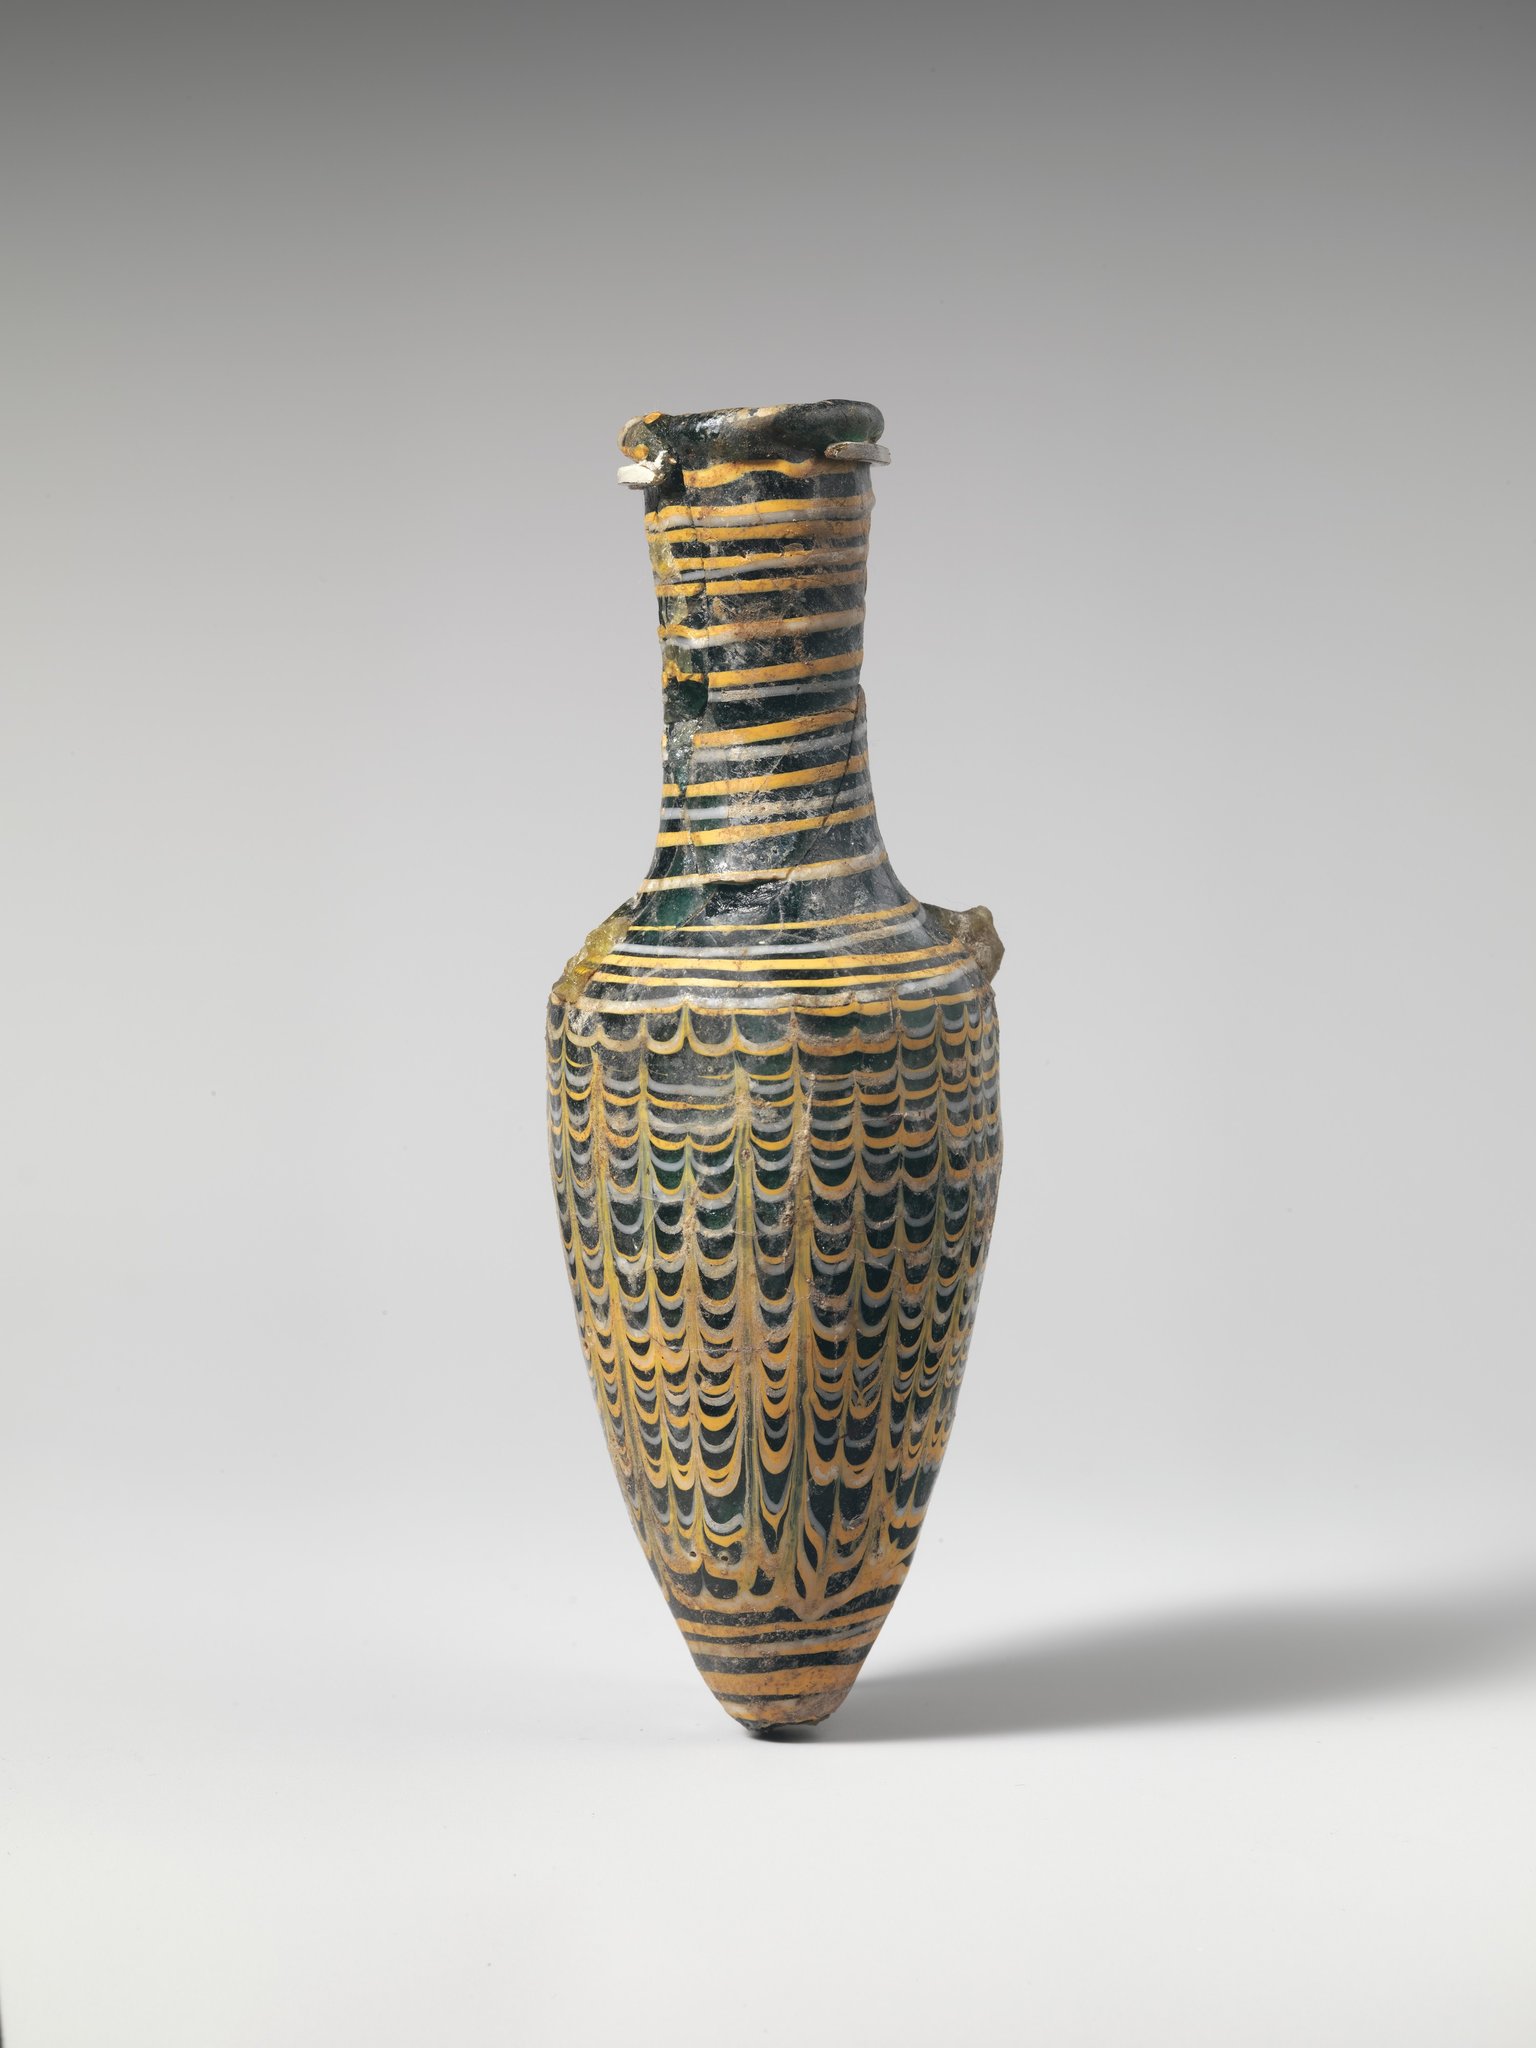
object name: amphoriskos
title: Glass amphoriskos (perfume bottle)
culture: greek, cypriot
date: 100-1 BCE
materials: glass